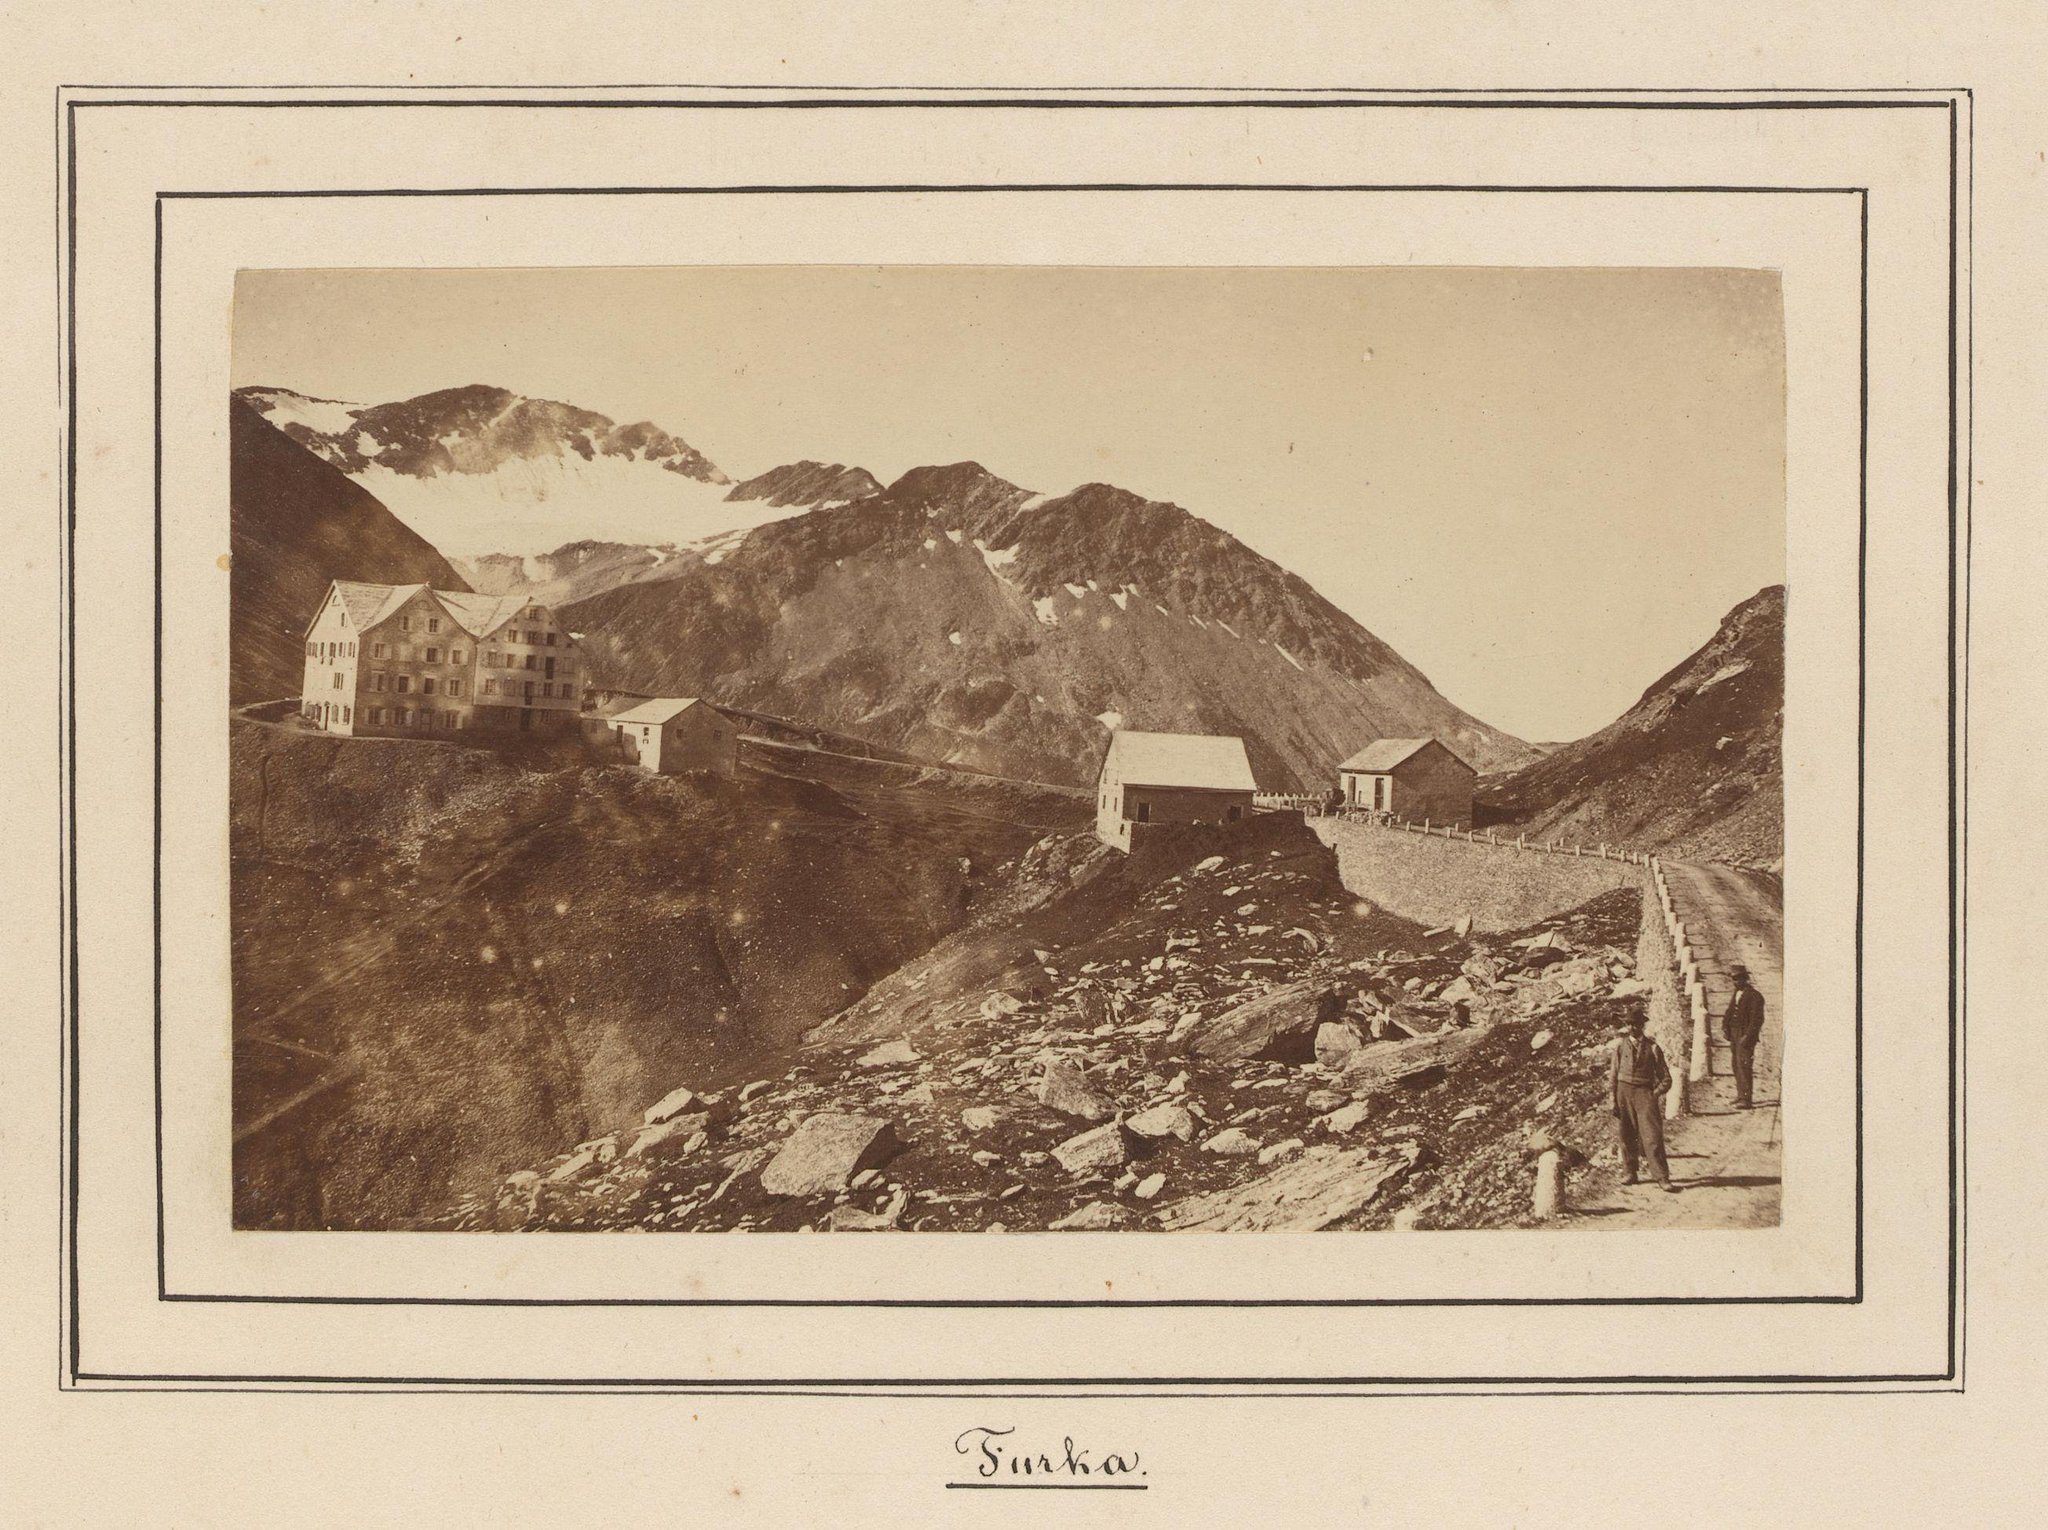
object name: photograph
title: Furka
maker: Anonymous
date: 1870-1890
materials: paper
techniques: albumen print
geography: furkapas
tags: hotel, hostelry, inn, mountains